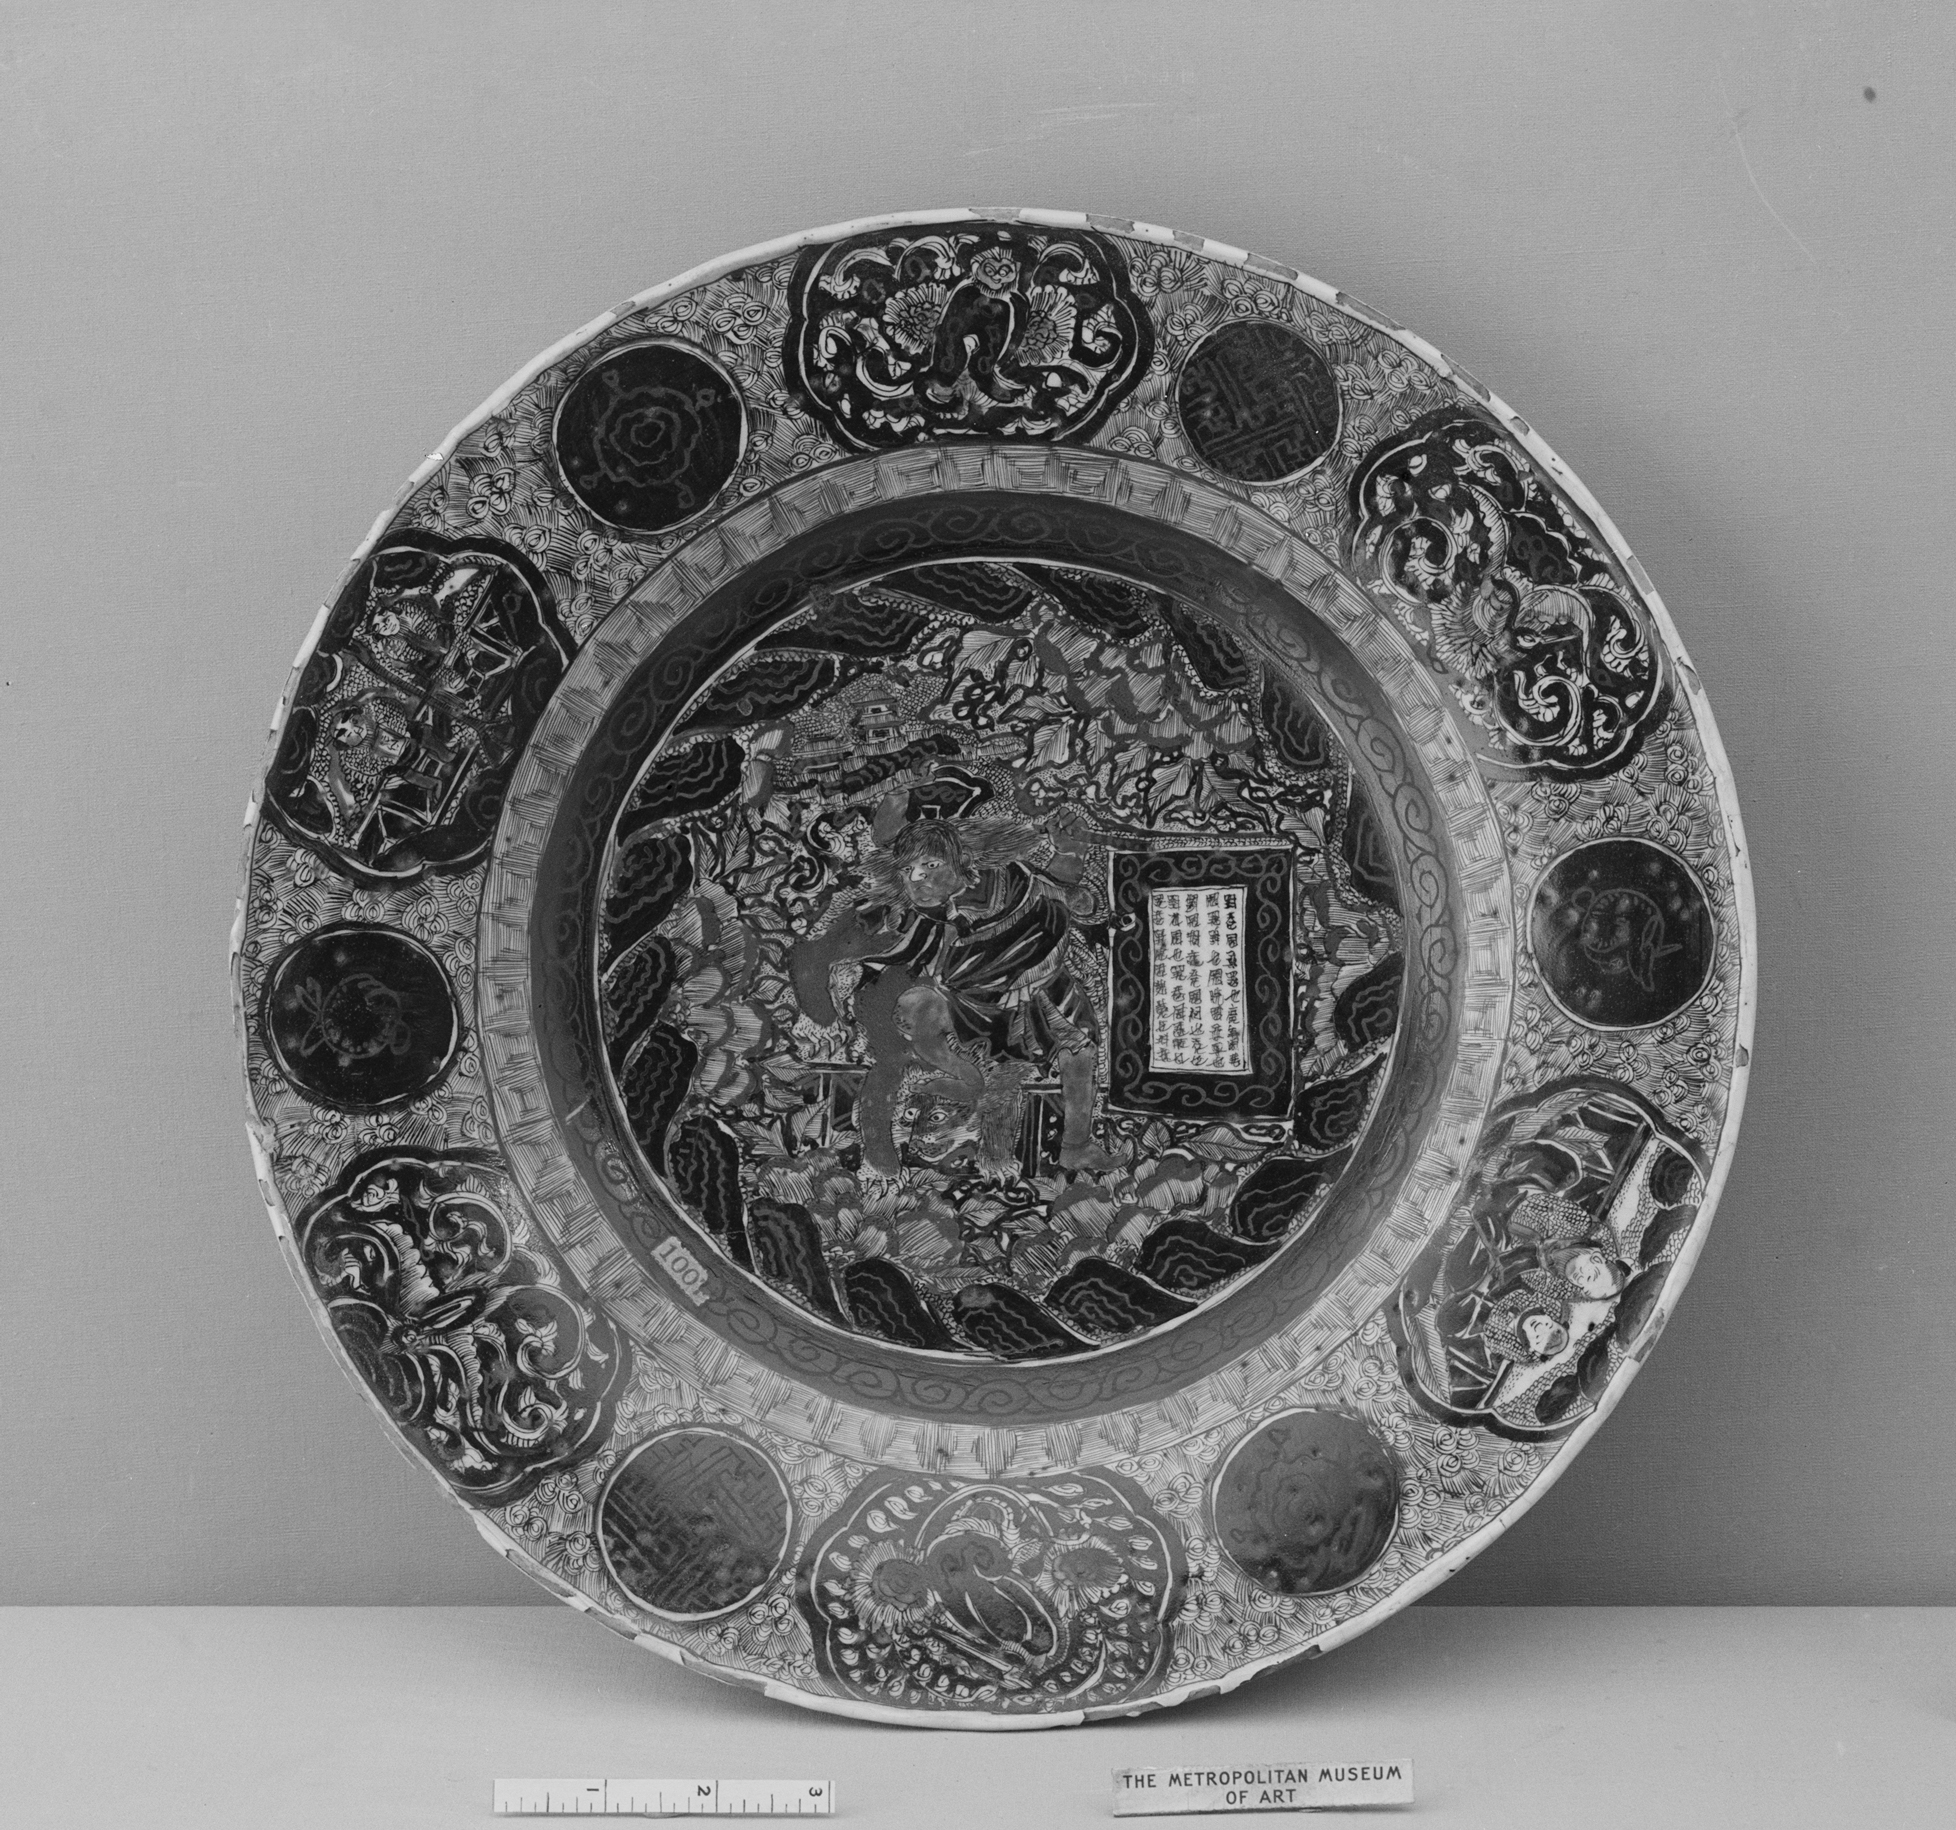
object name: dish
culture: japanese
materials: ceramic, glaze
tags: men